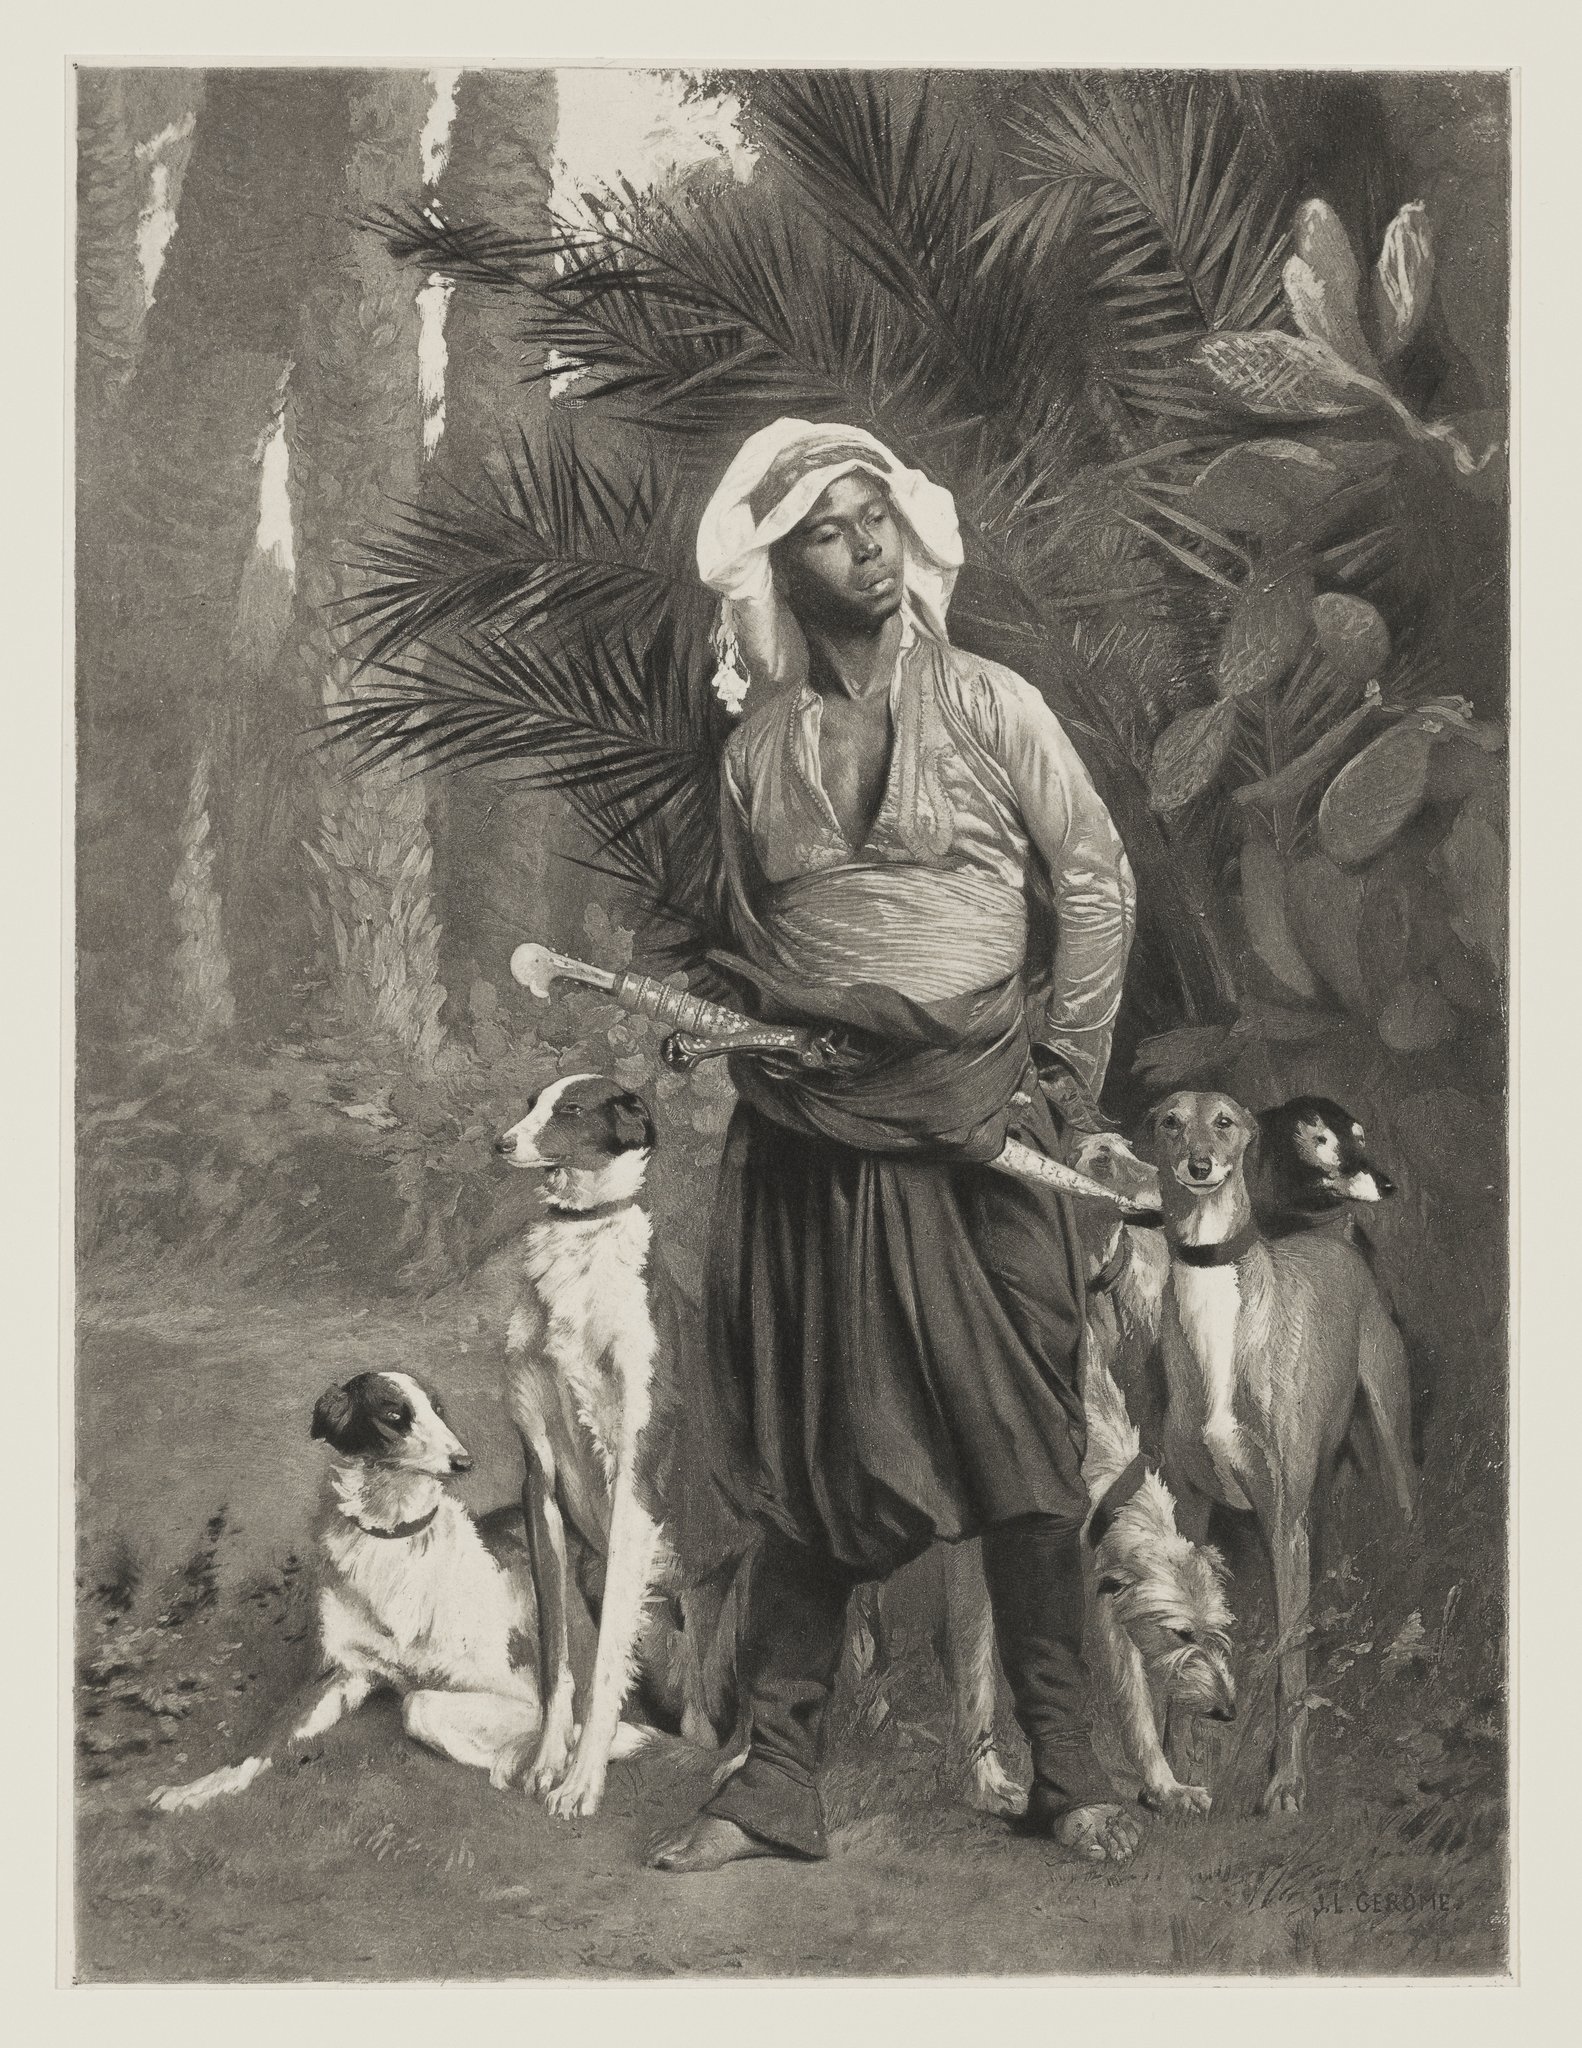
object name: print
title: Master of the Hounds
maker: jean-léon gérôme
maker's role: artist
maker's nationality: french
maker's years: 1824-1904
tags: men,dogs